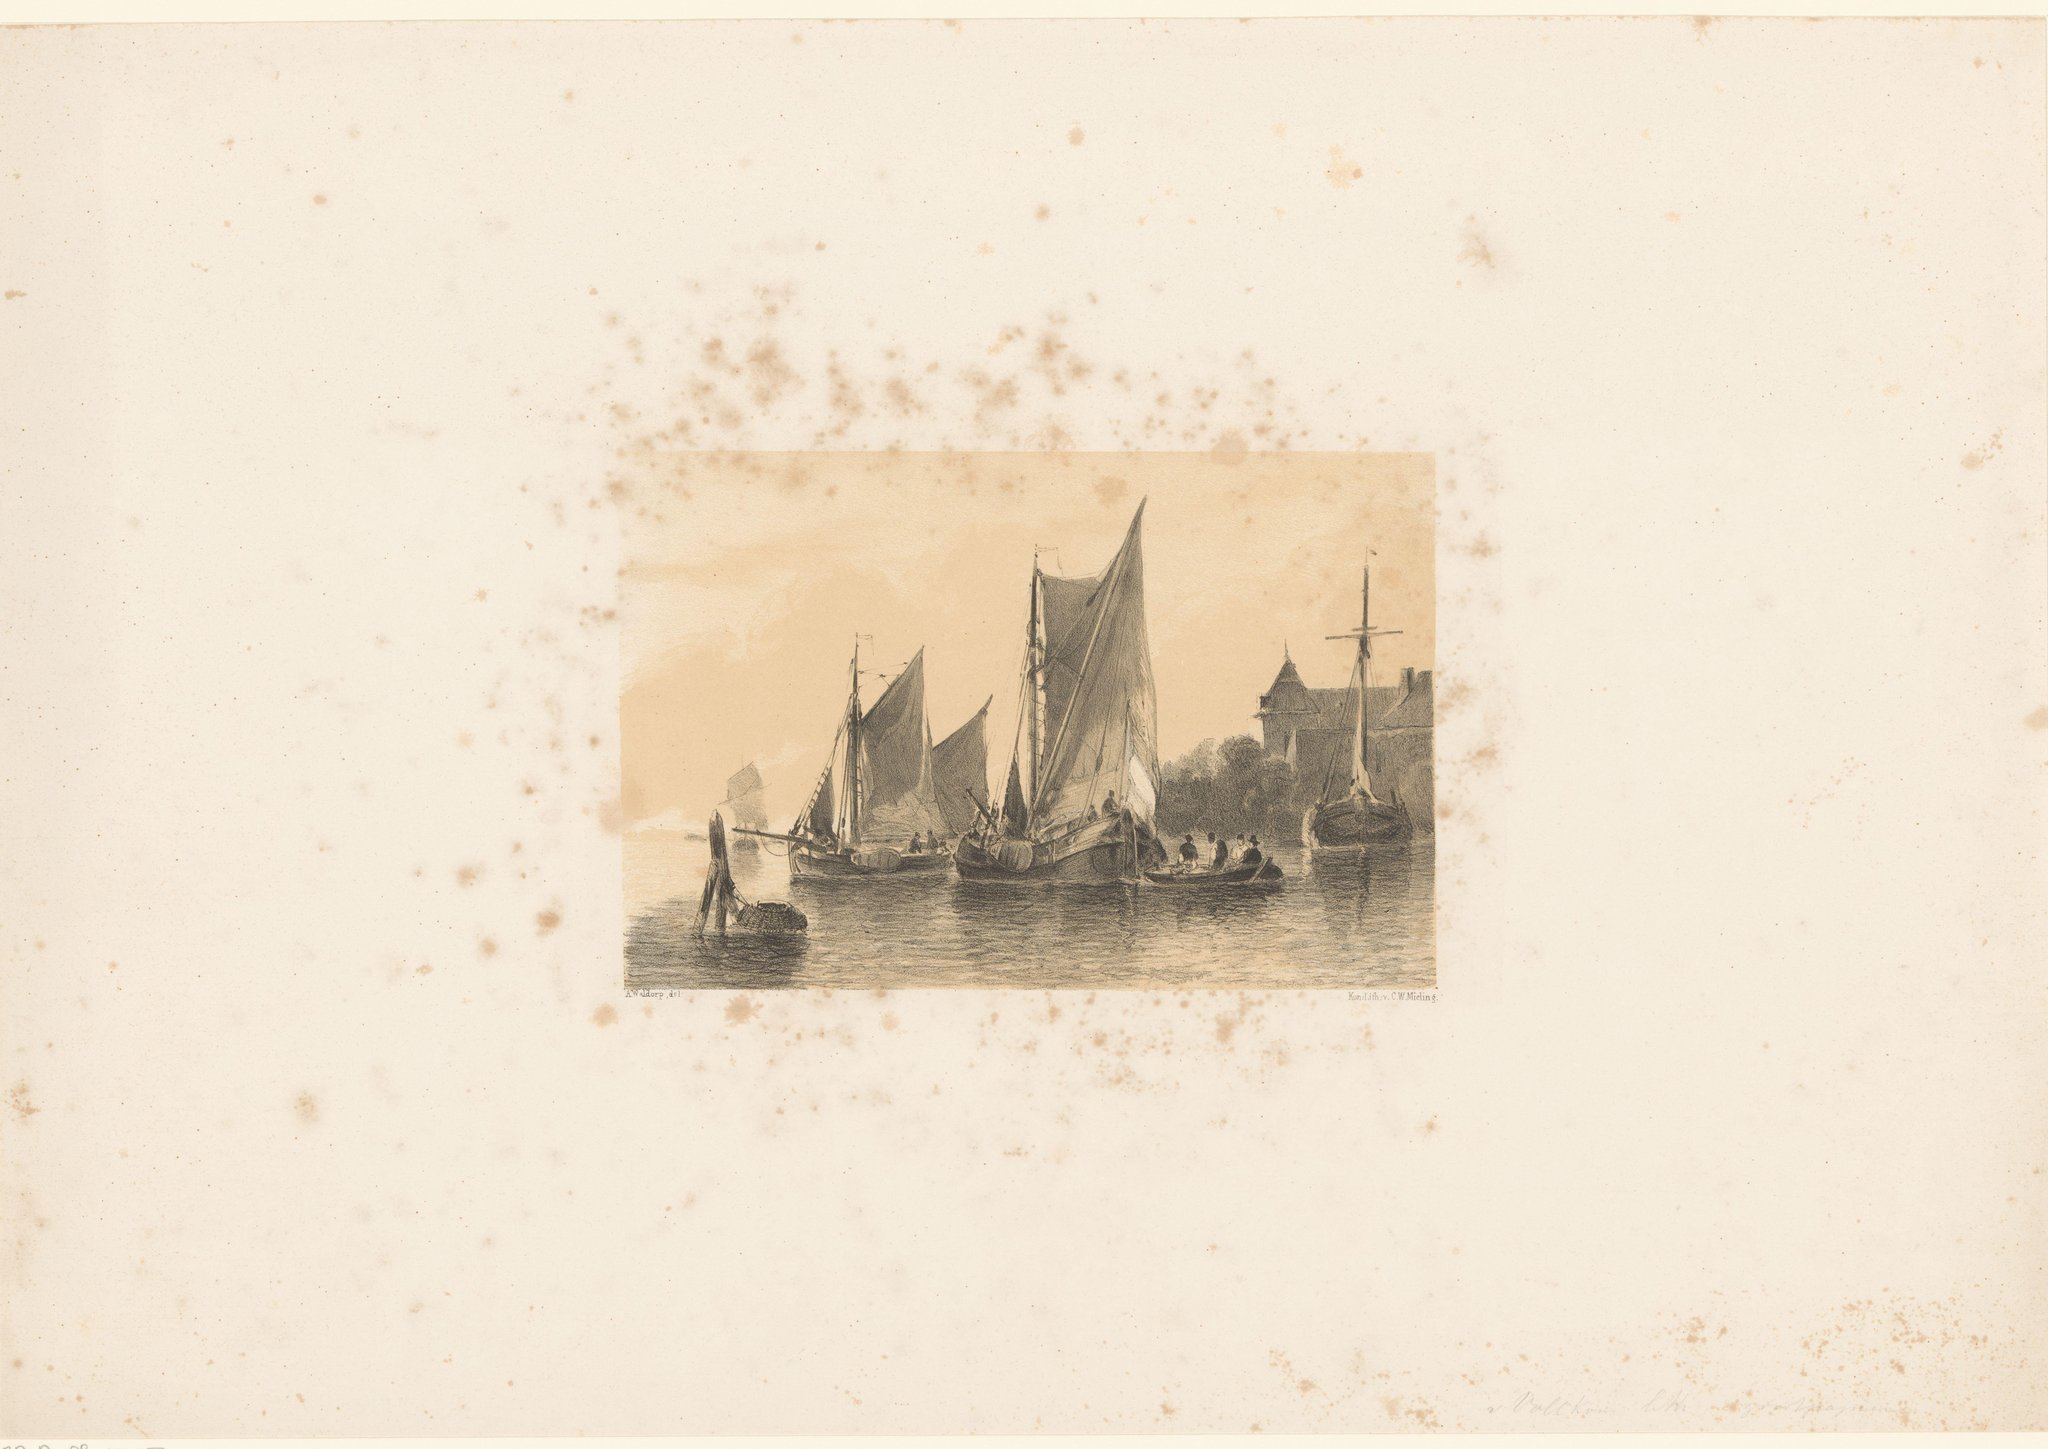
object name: print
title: Zeilboten op rivier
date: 1847-1865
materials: paper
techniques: tone lithography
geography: the hague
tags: sailing-ship, sailing-boat, river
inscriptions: collector's mark: Lugt 2228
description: Zeilboten en een roeiboot varend op een rivier.